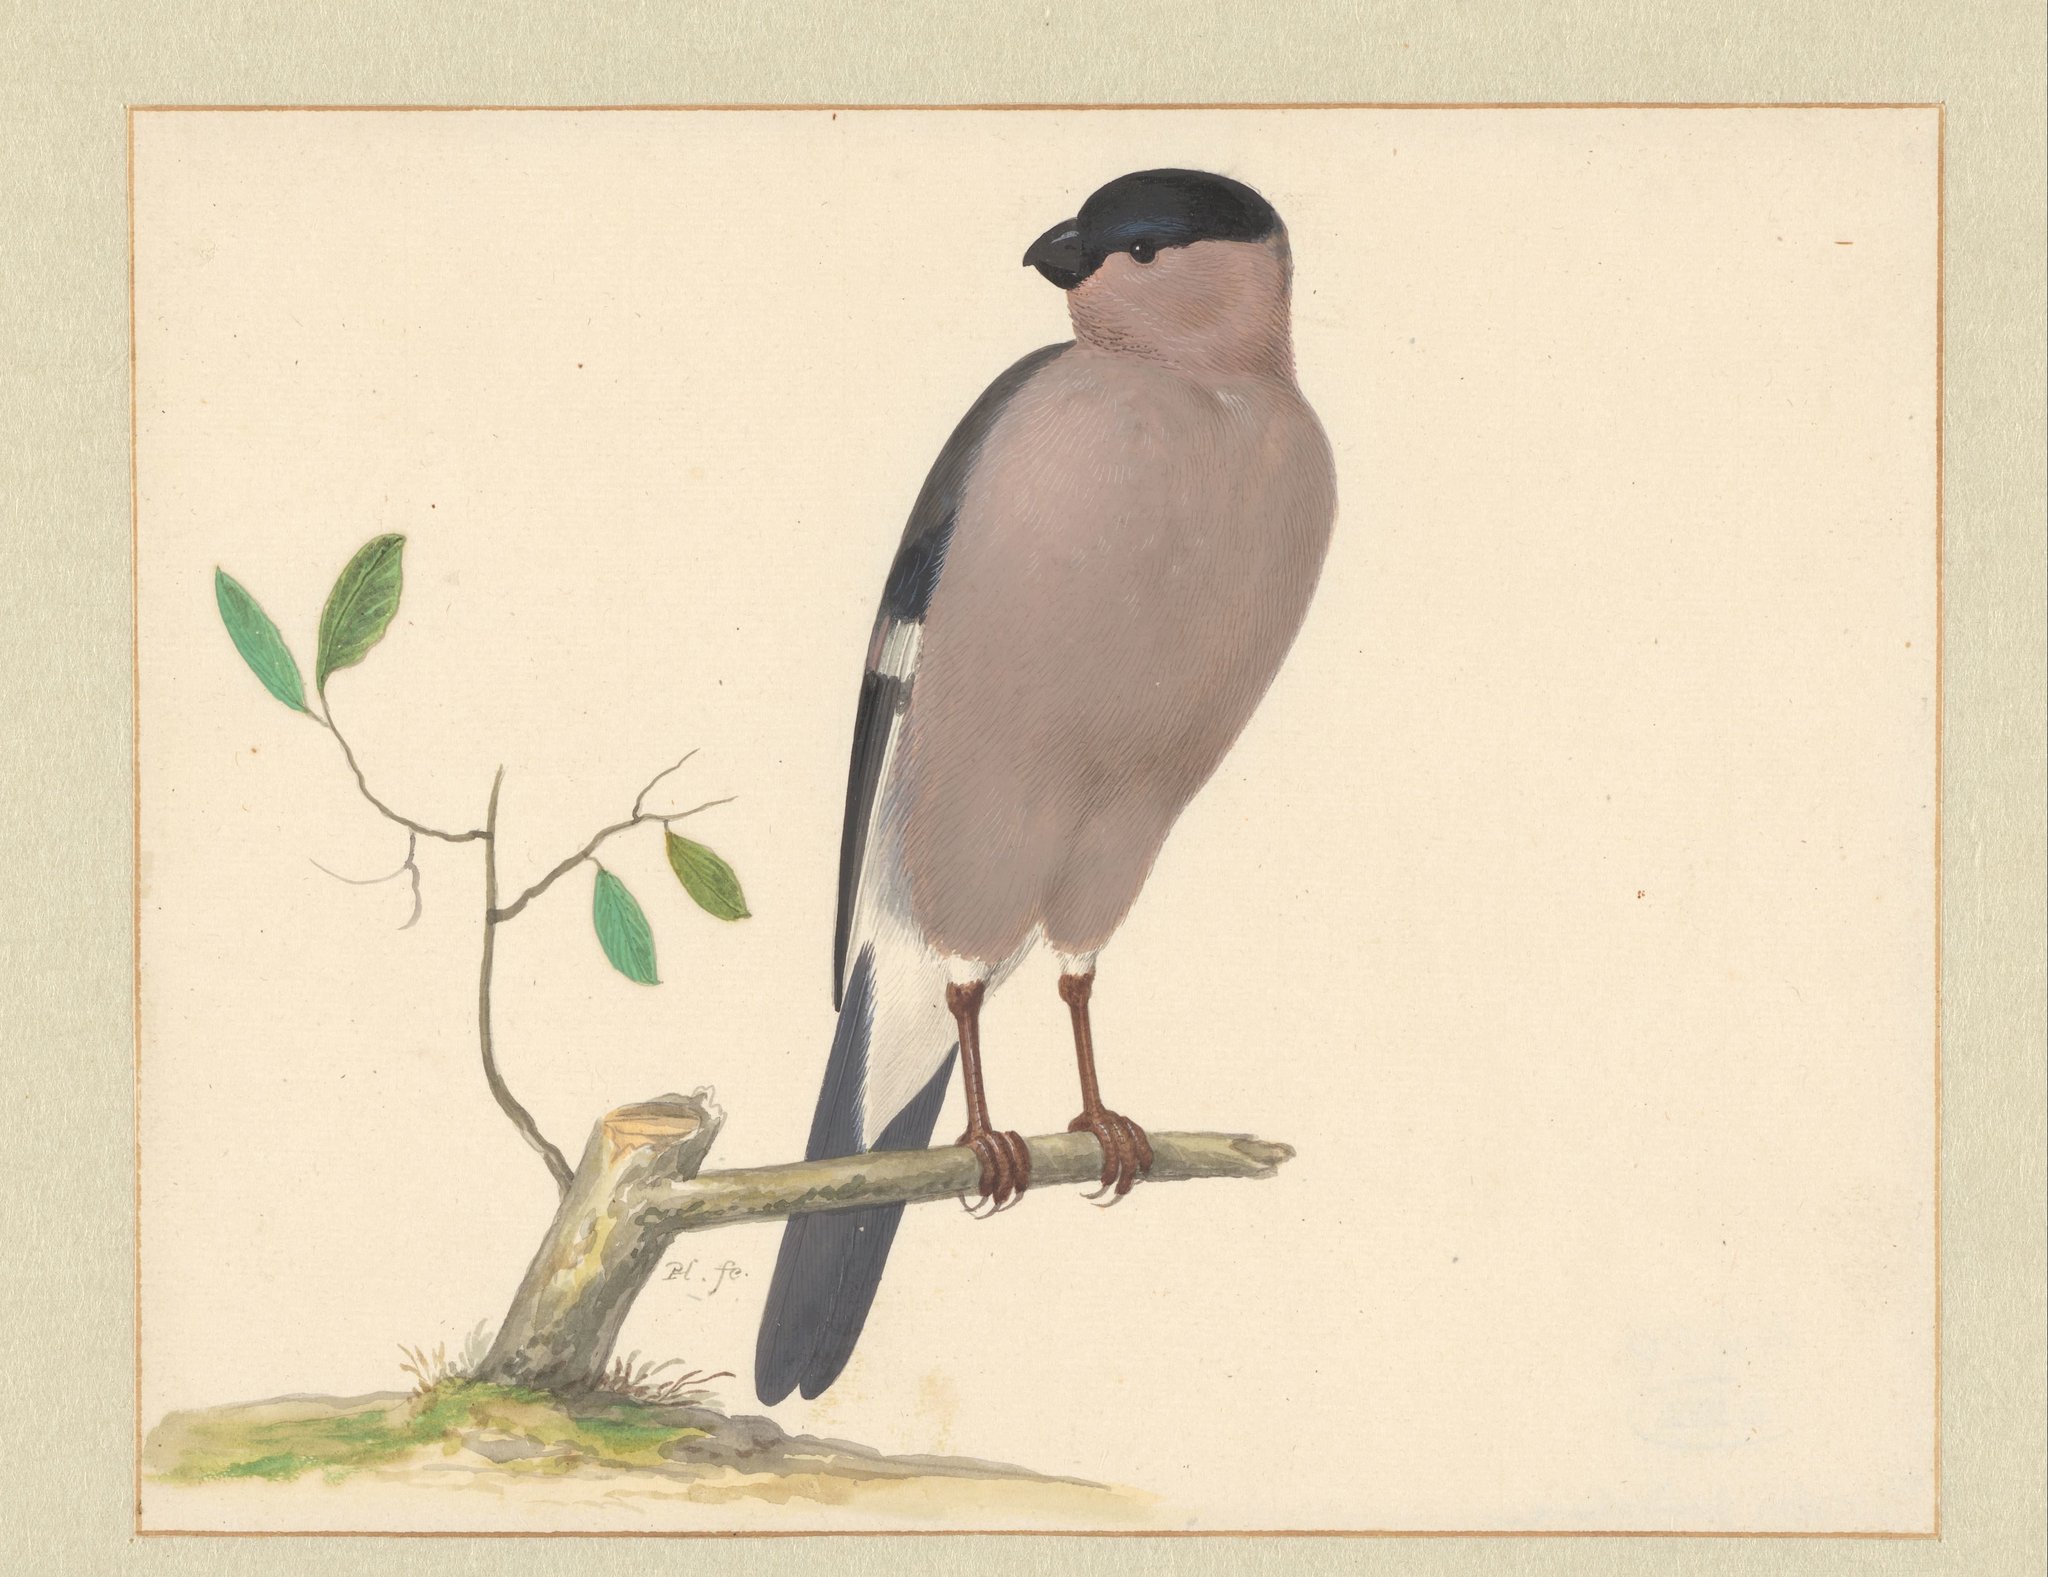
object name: drawing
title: Goudvink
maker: pieter holsteyn (i)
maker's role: draughtsman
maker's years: 1580-1662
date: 1600-1662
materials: gouache, paper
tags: song-birds: bullfinch